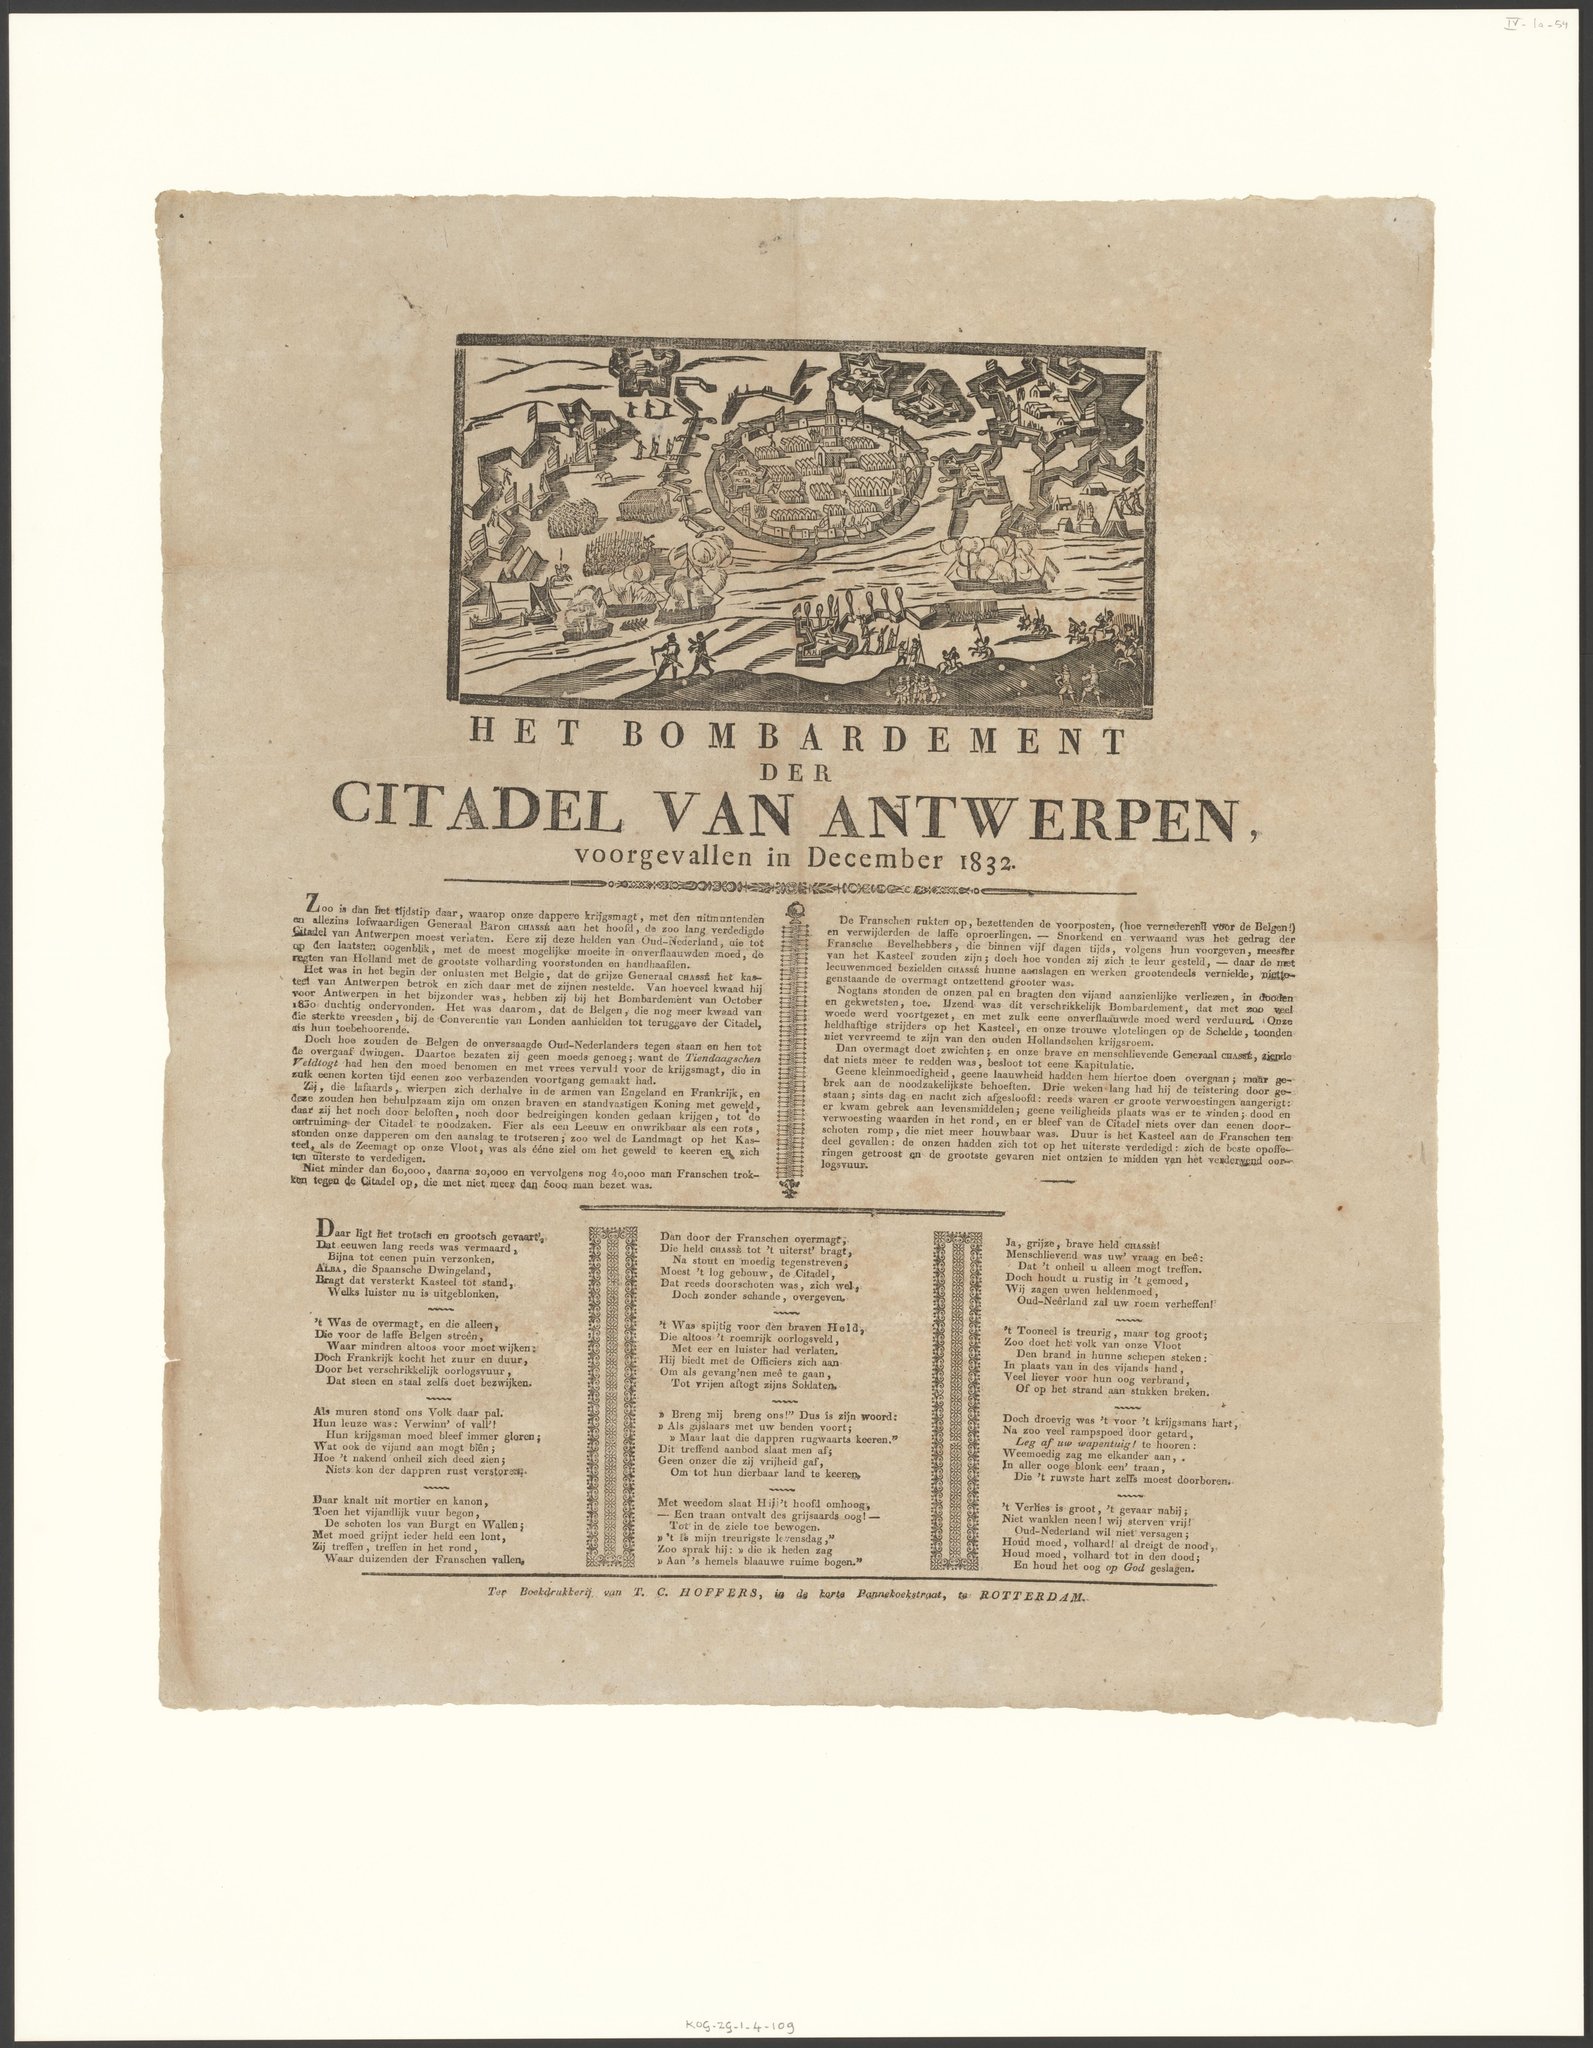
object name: print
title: Het Bombardement der Citadel van Antwerpen, voorgevallen in December 1832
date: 1832-1833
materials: paper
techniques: letterpress printing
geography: rotterdam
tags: siege, position war